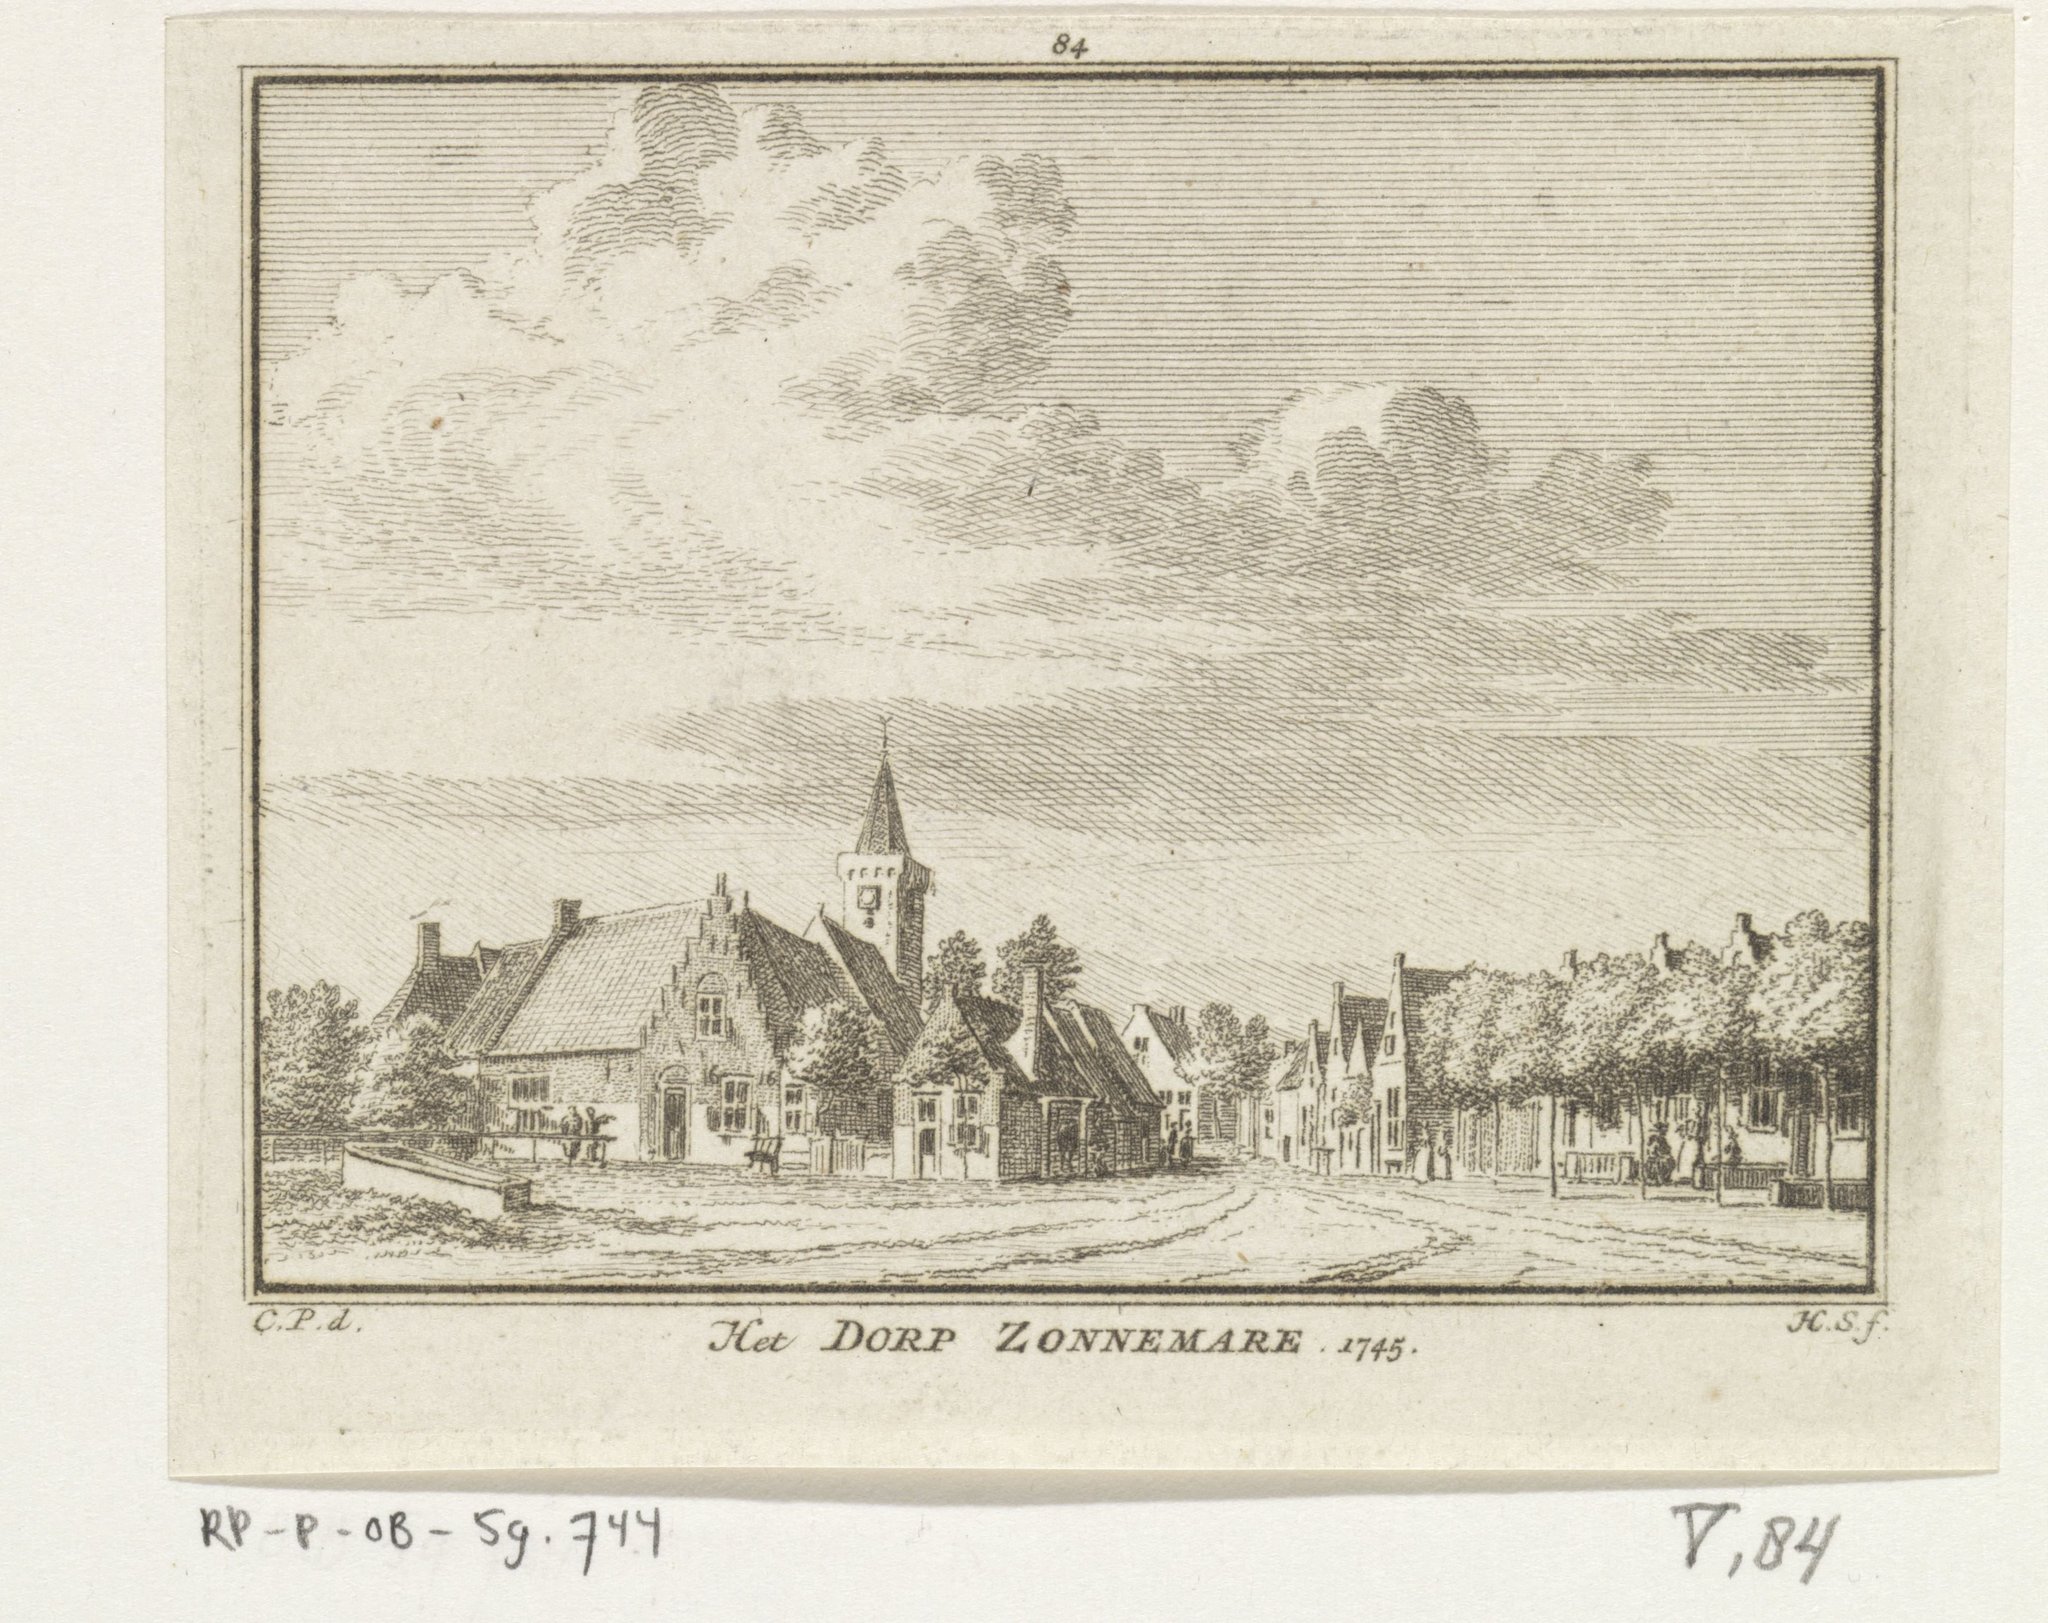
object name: book illustration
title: Gezicht op Zonnemaire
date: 1754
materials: paper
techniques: etching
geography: haarlem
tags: church (exterior), public road in village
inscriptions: collector's mark: Lugt 2228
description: Prent gebruikt in: Het verheerlykt Nederland of kabinet van hedendaagsche gezigten van steden, dorpen, sloten ... en andere voornaame stad- en landgebouwen, in en omtrent alle de byzondere Vereenigde Nederlandsche Provinciën : gedurende de laatste jaaren door vermaarden kunsttekenaren na het leven getekent en ... in 't koper gebragt ... dienende tot opheldering der beschryvinge van den Tegenwoordigen Staat der Vereenigde Nederlanden. Deel V, 1754. Amsterdam: Isaac Tirion, 1745-1774.